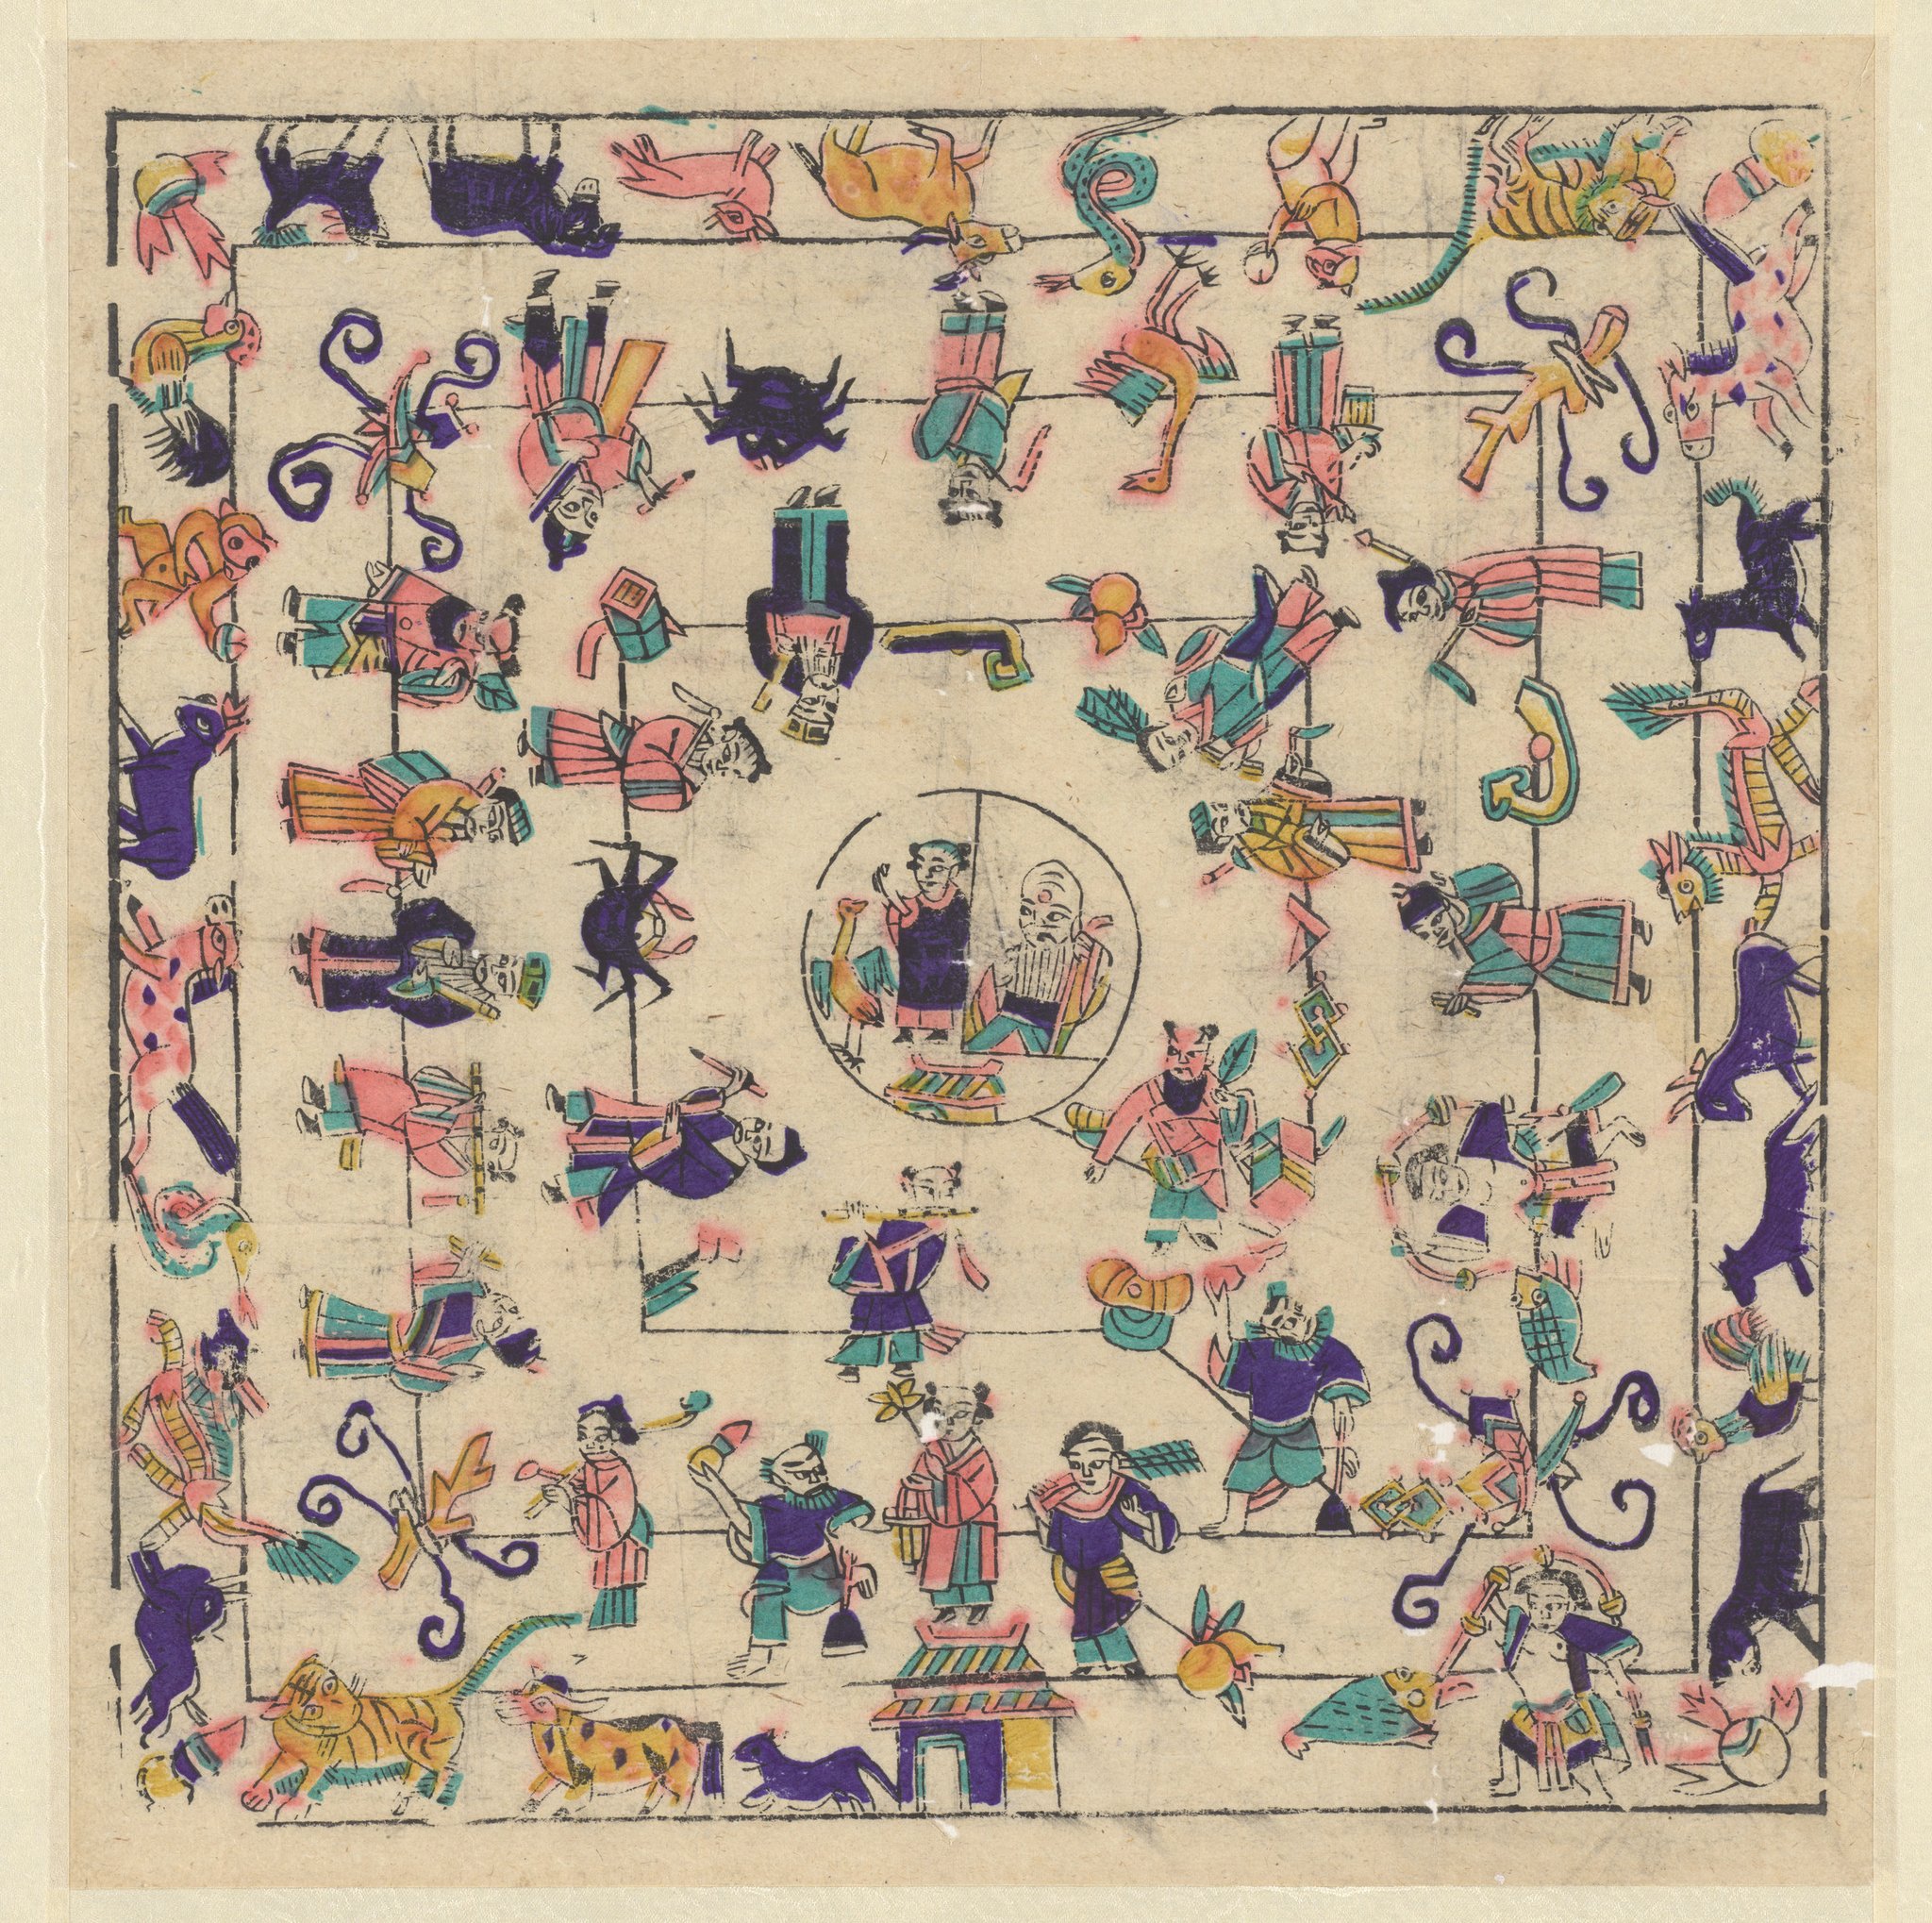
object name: print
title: Eight Immortals and Twelve Zodiac Animals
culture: chinese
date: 1701-1800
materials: ink, paper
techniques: hand coloring, woodblock print